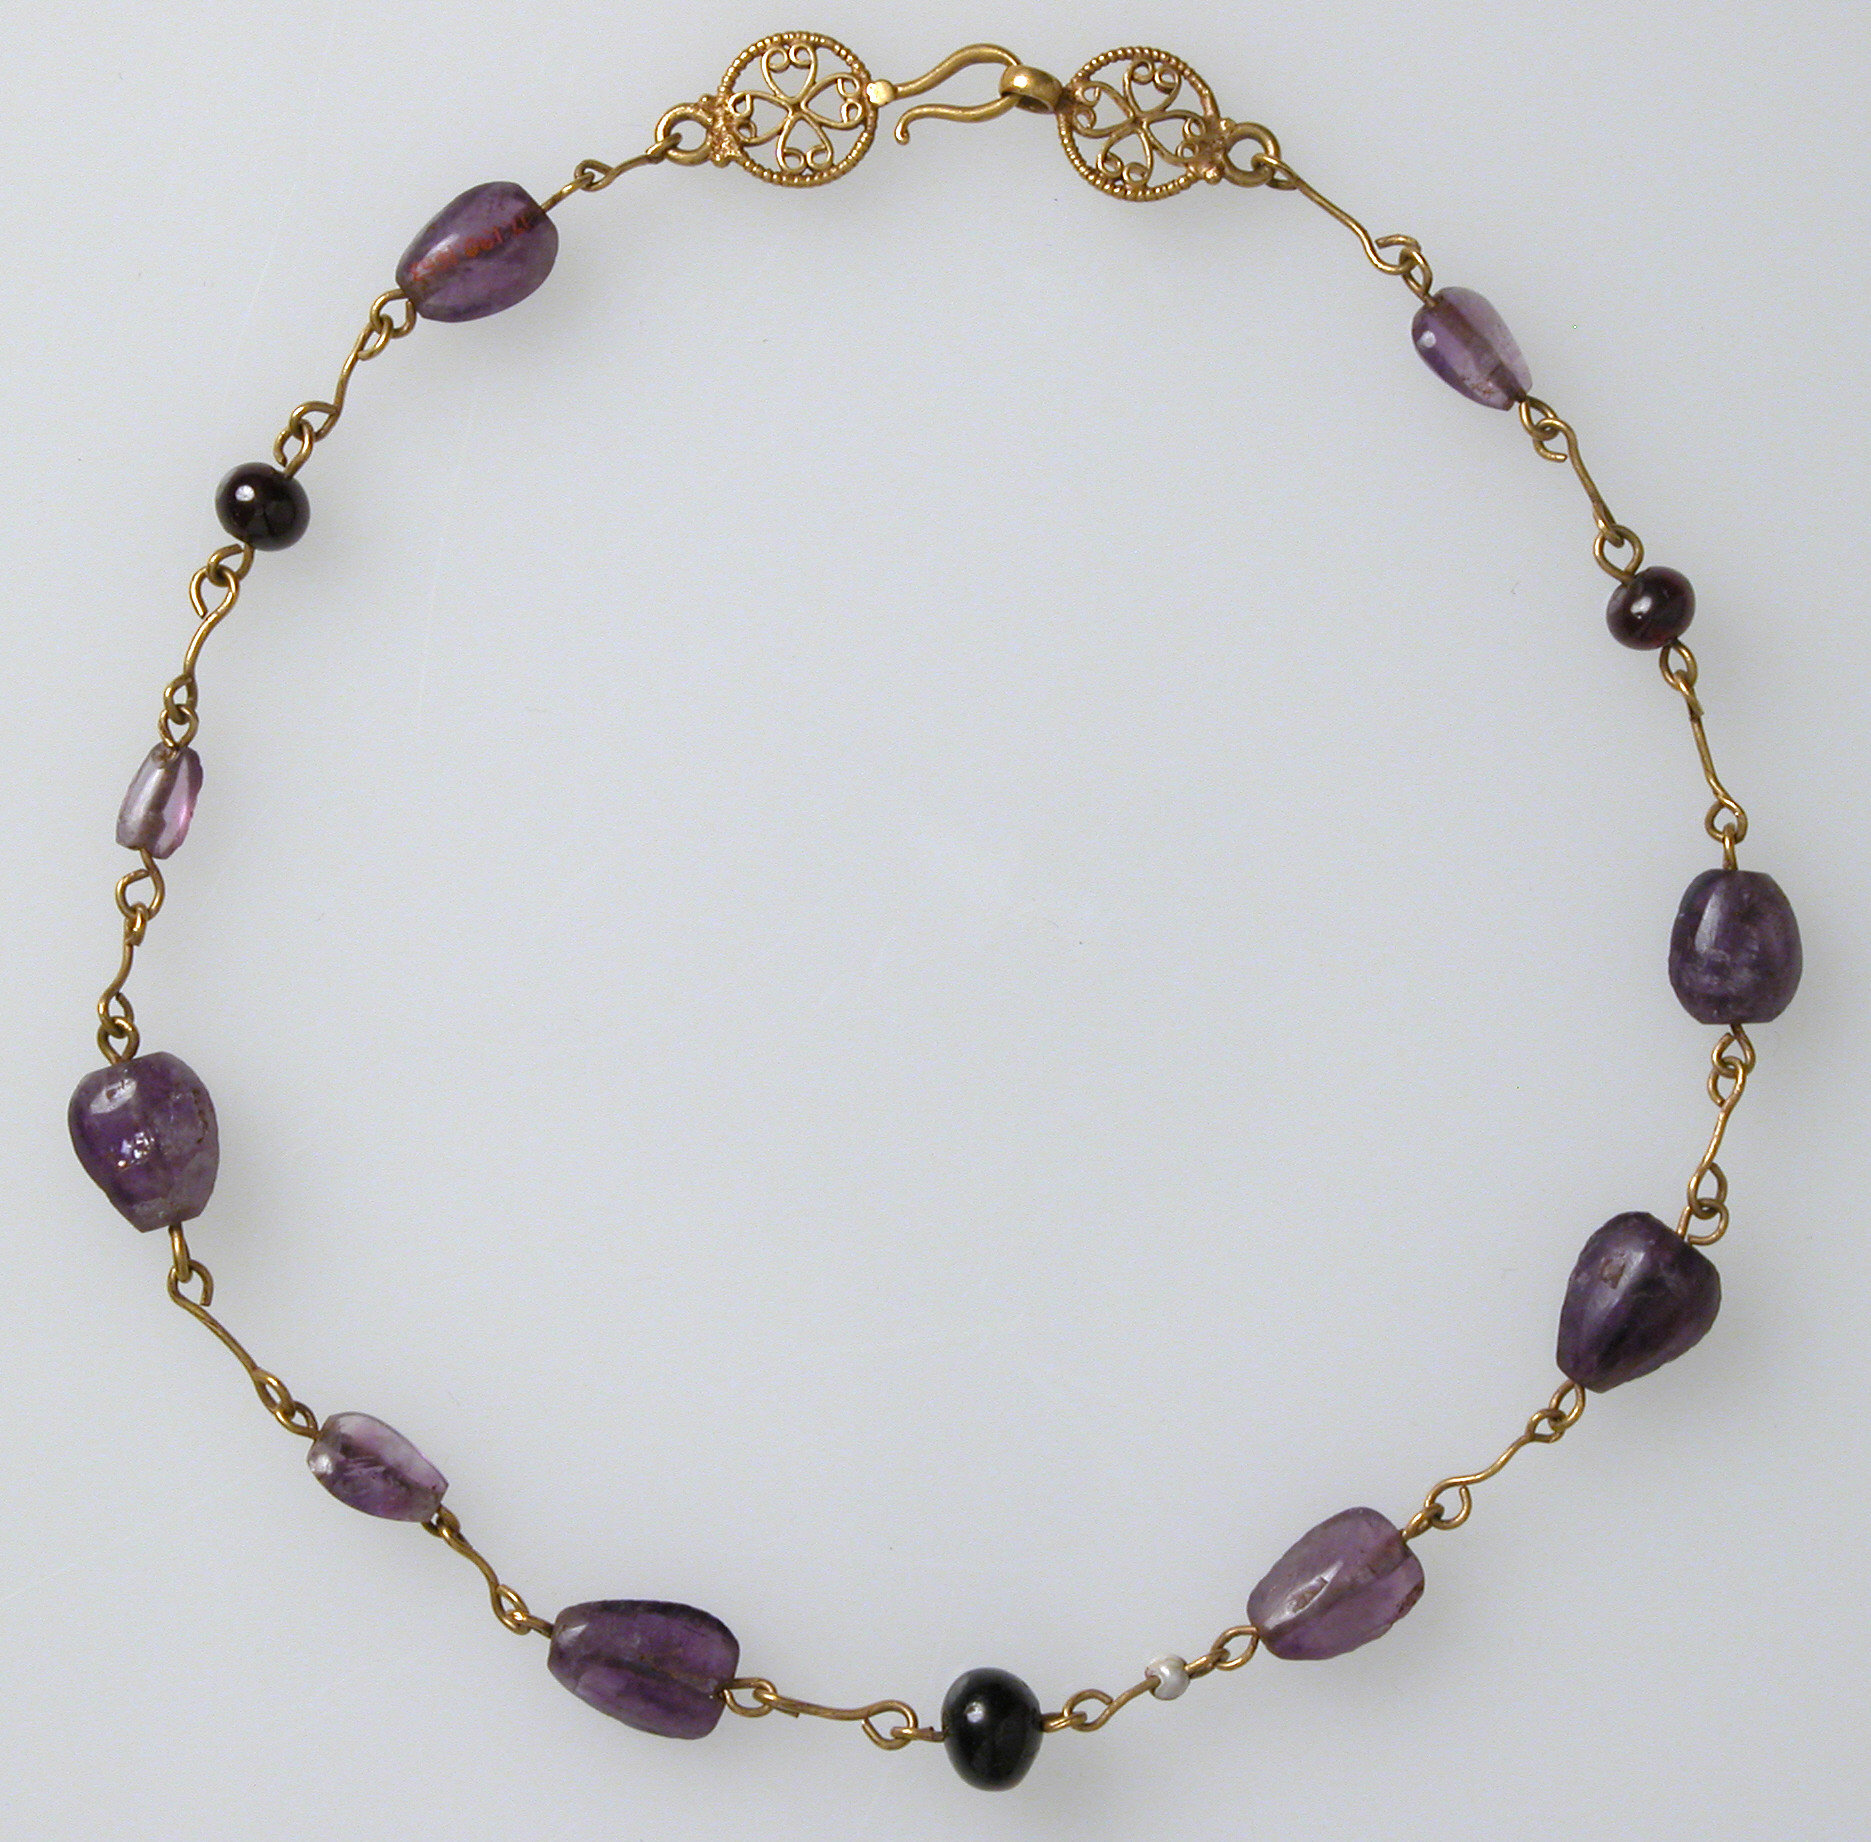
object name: necklace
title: Gold Necklace with Amethysts, Glass Beads, and a Pearl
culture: byzantine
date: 500-700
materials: gemstone, glass, gold, pearl